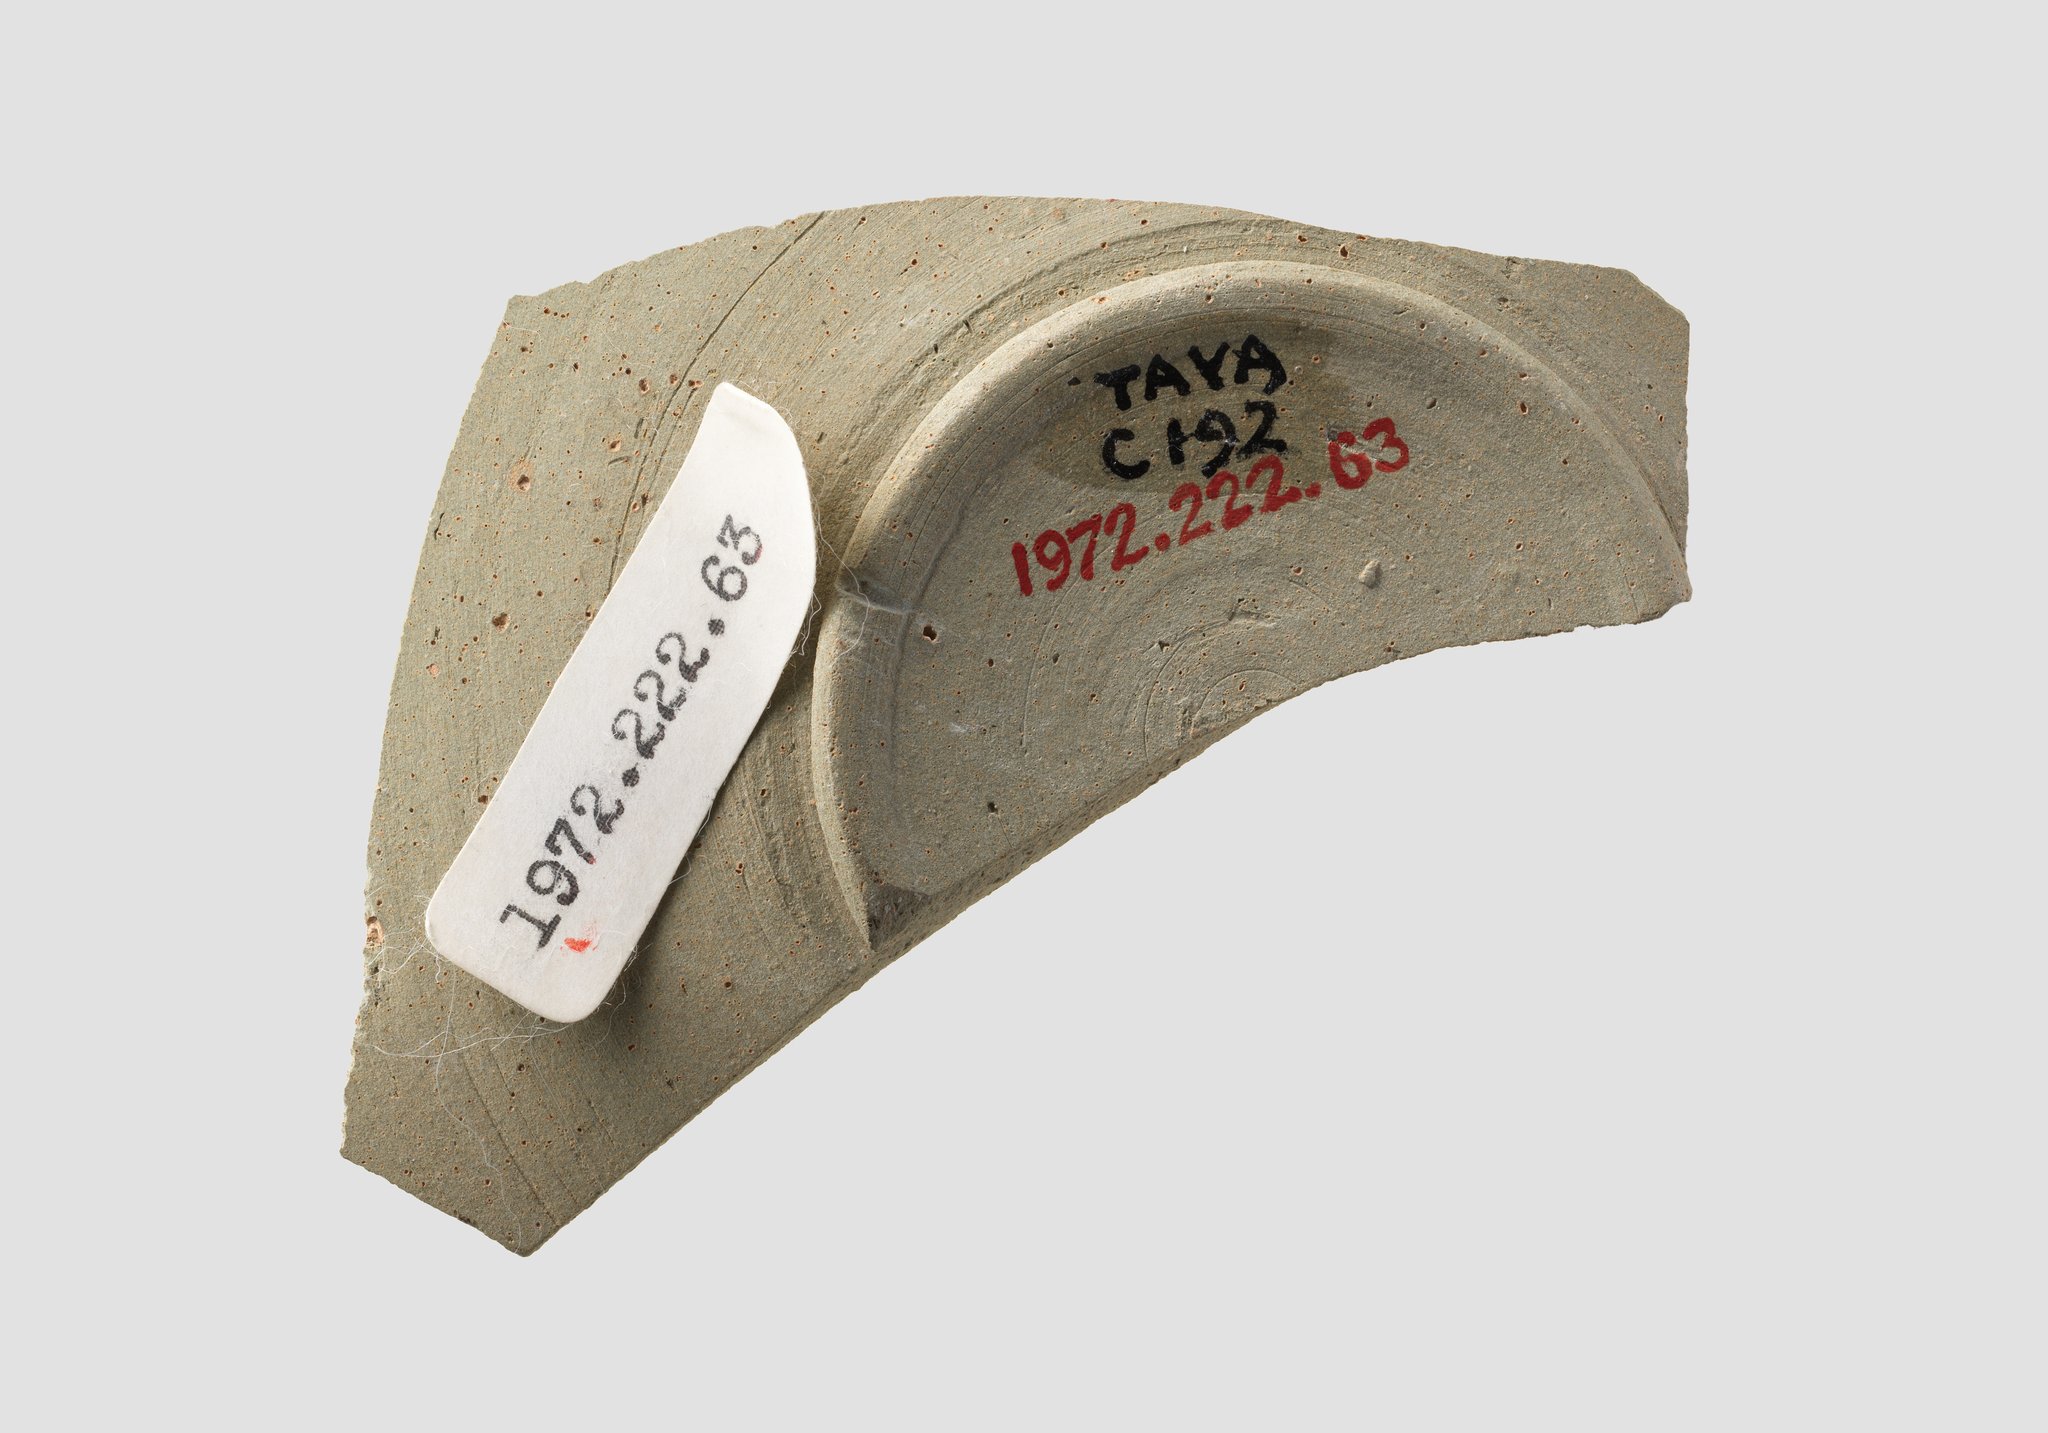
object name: sherd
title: Ring base sherd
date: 2333-2001 BCE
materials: ceramic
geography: mesopotamia